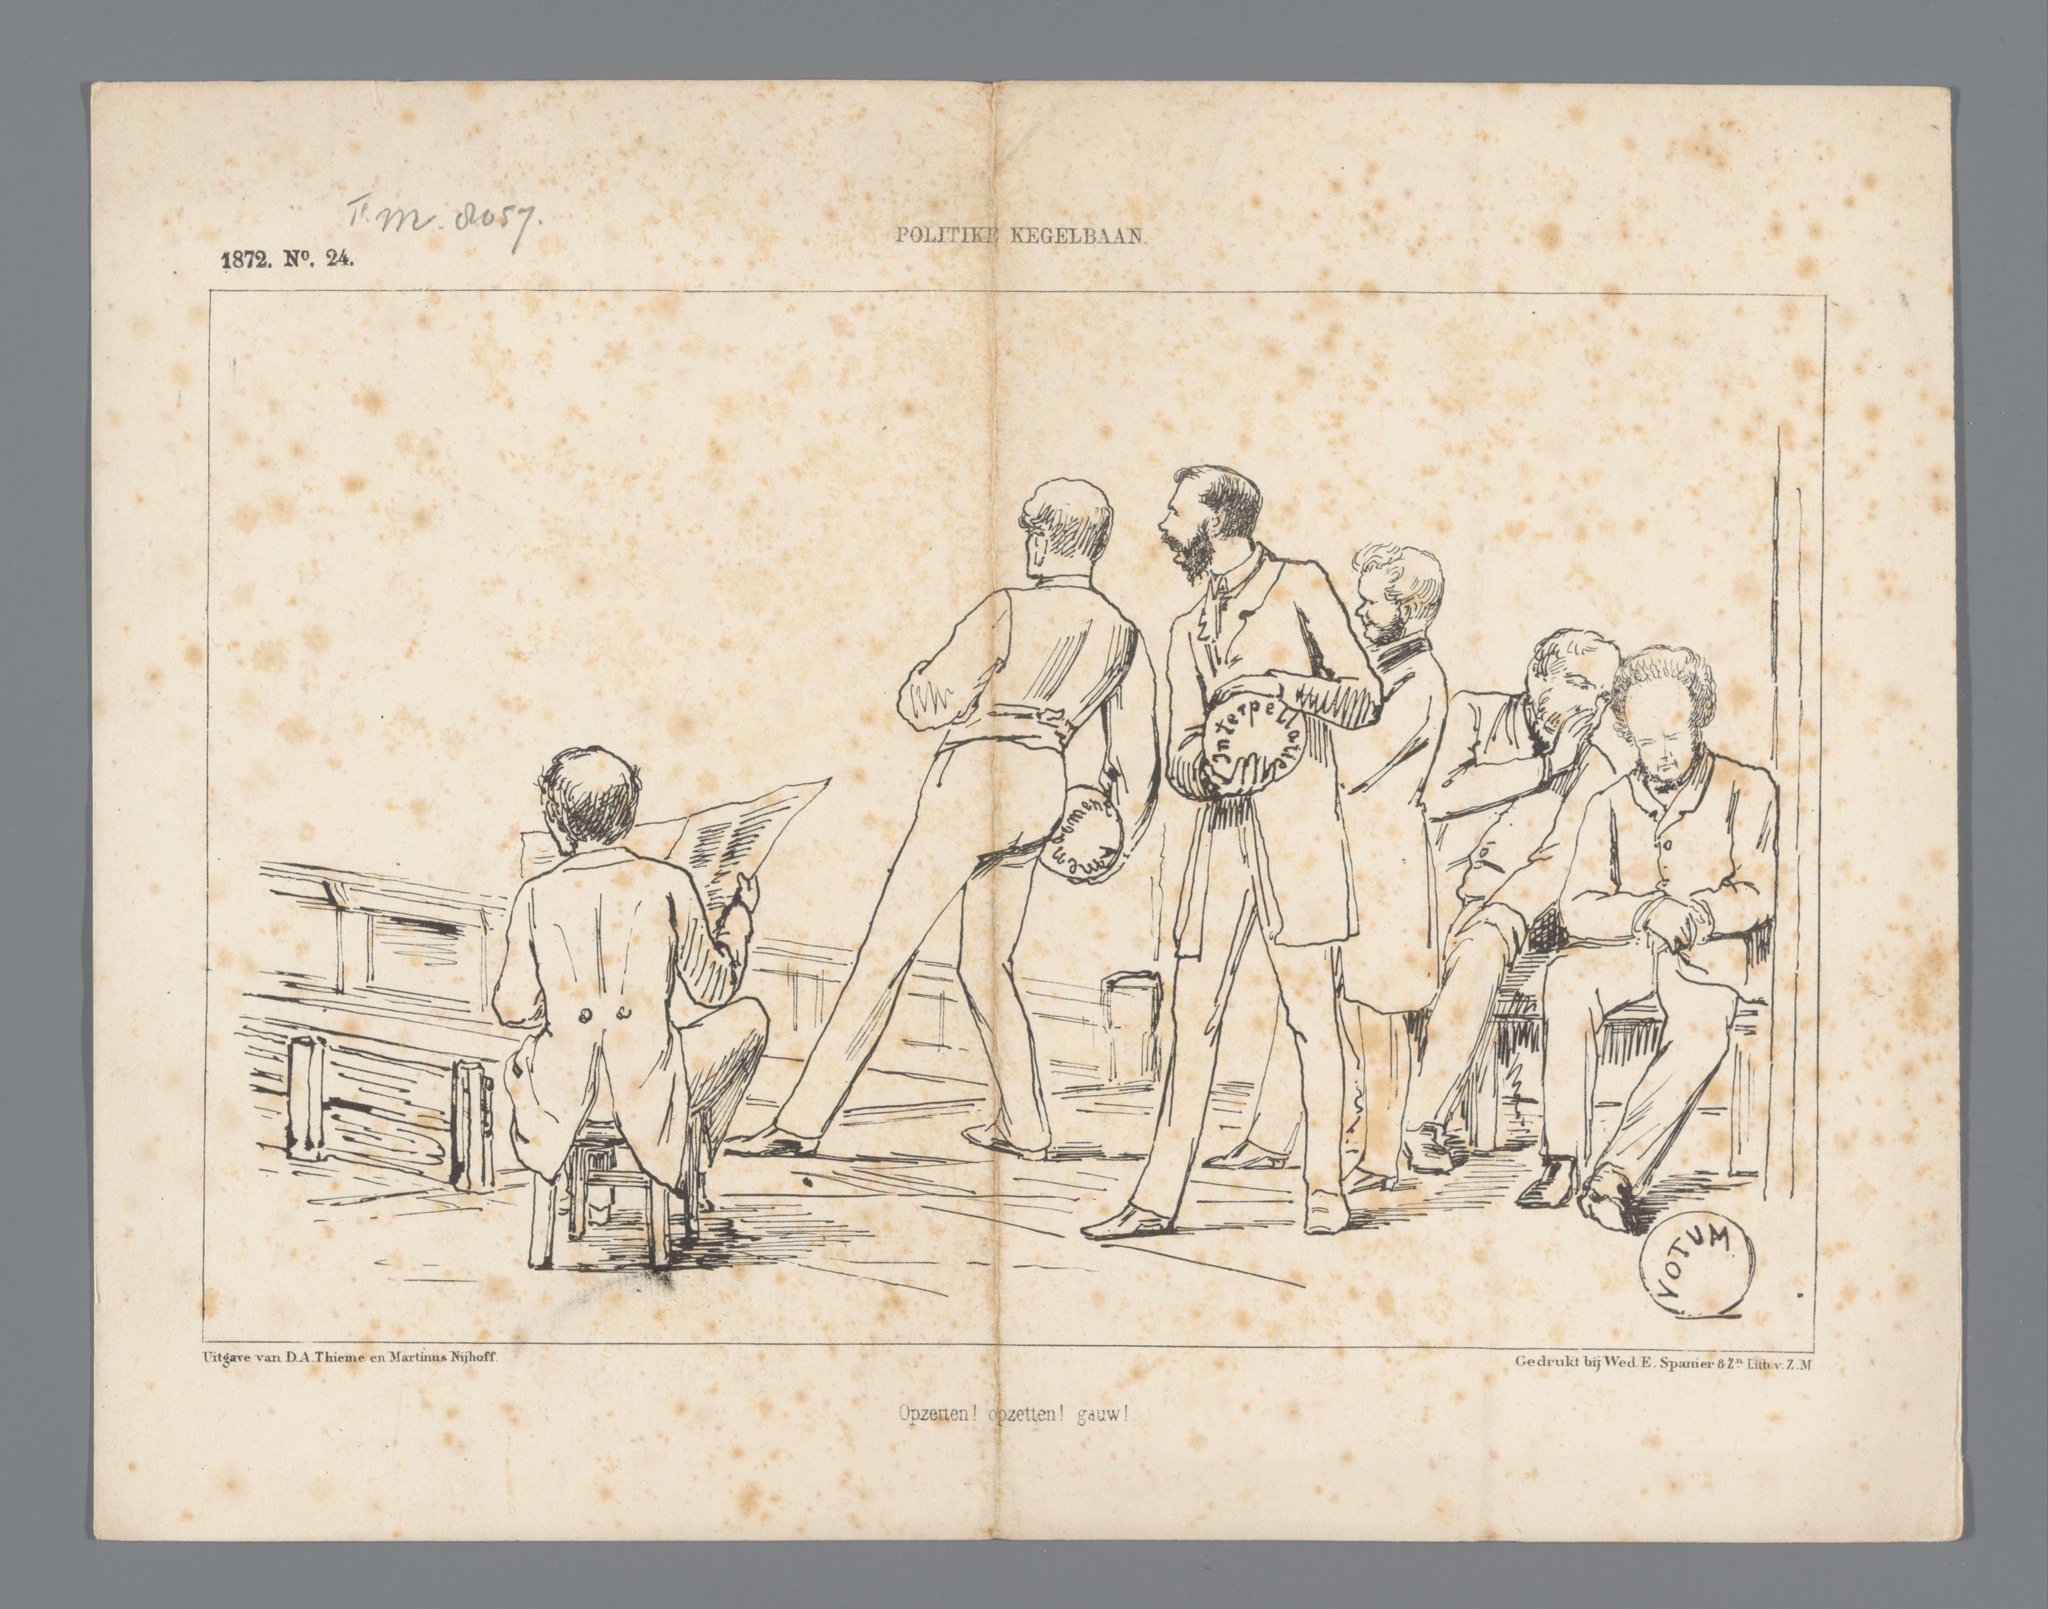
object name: print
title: Spotprent op de ministerië crisis, 1872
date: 1872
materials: paper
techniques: lithograph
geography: netherlands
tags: bowling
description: Spotprent op de uitbuiting van de ministerië crisis door de oppositie als kegelaars op de kegelbaan. Plaat verschenen bij het weekblad De Nederlandsche Spectator, nr. 24, 1872.